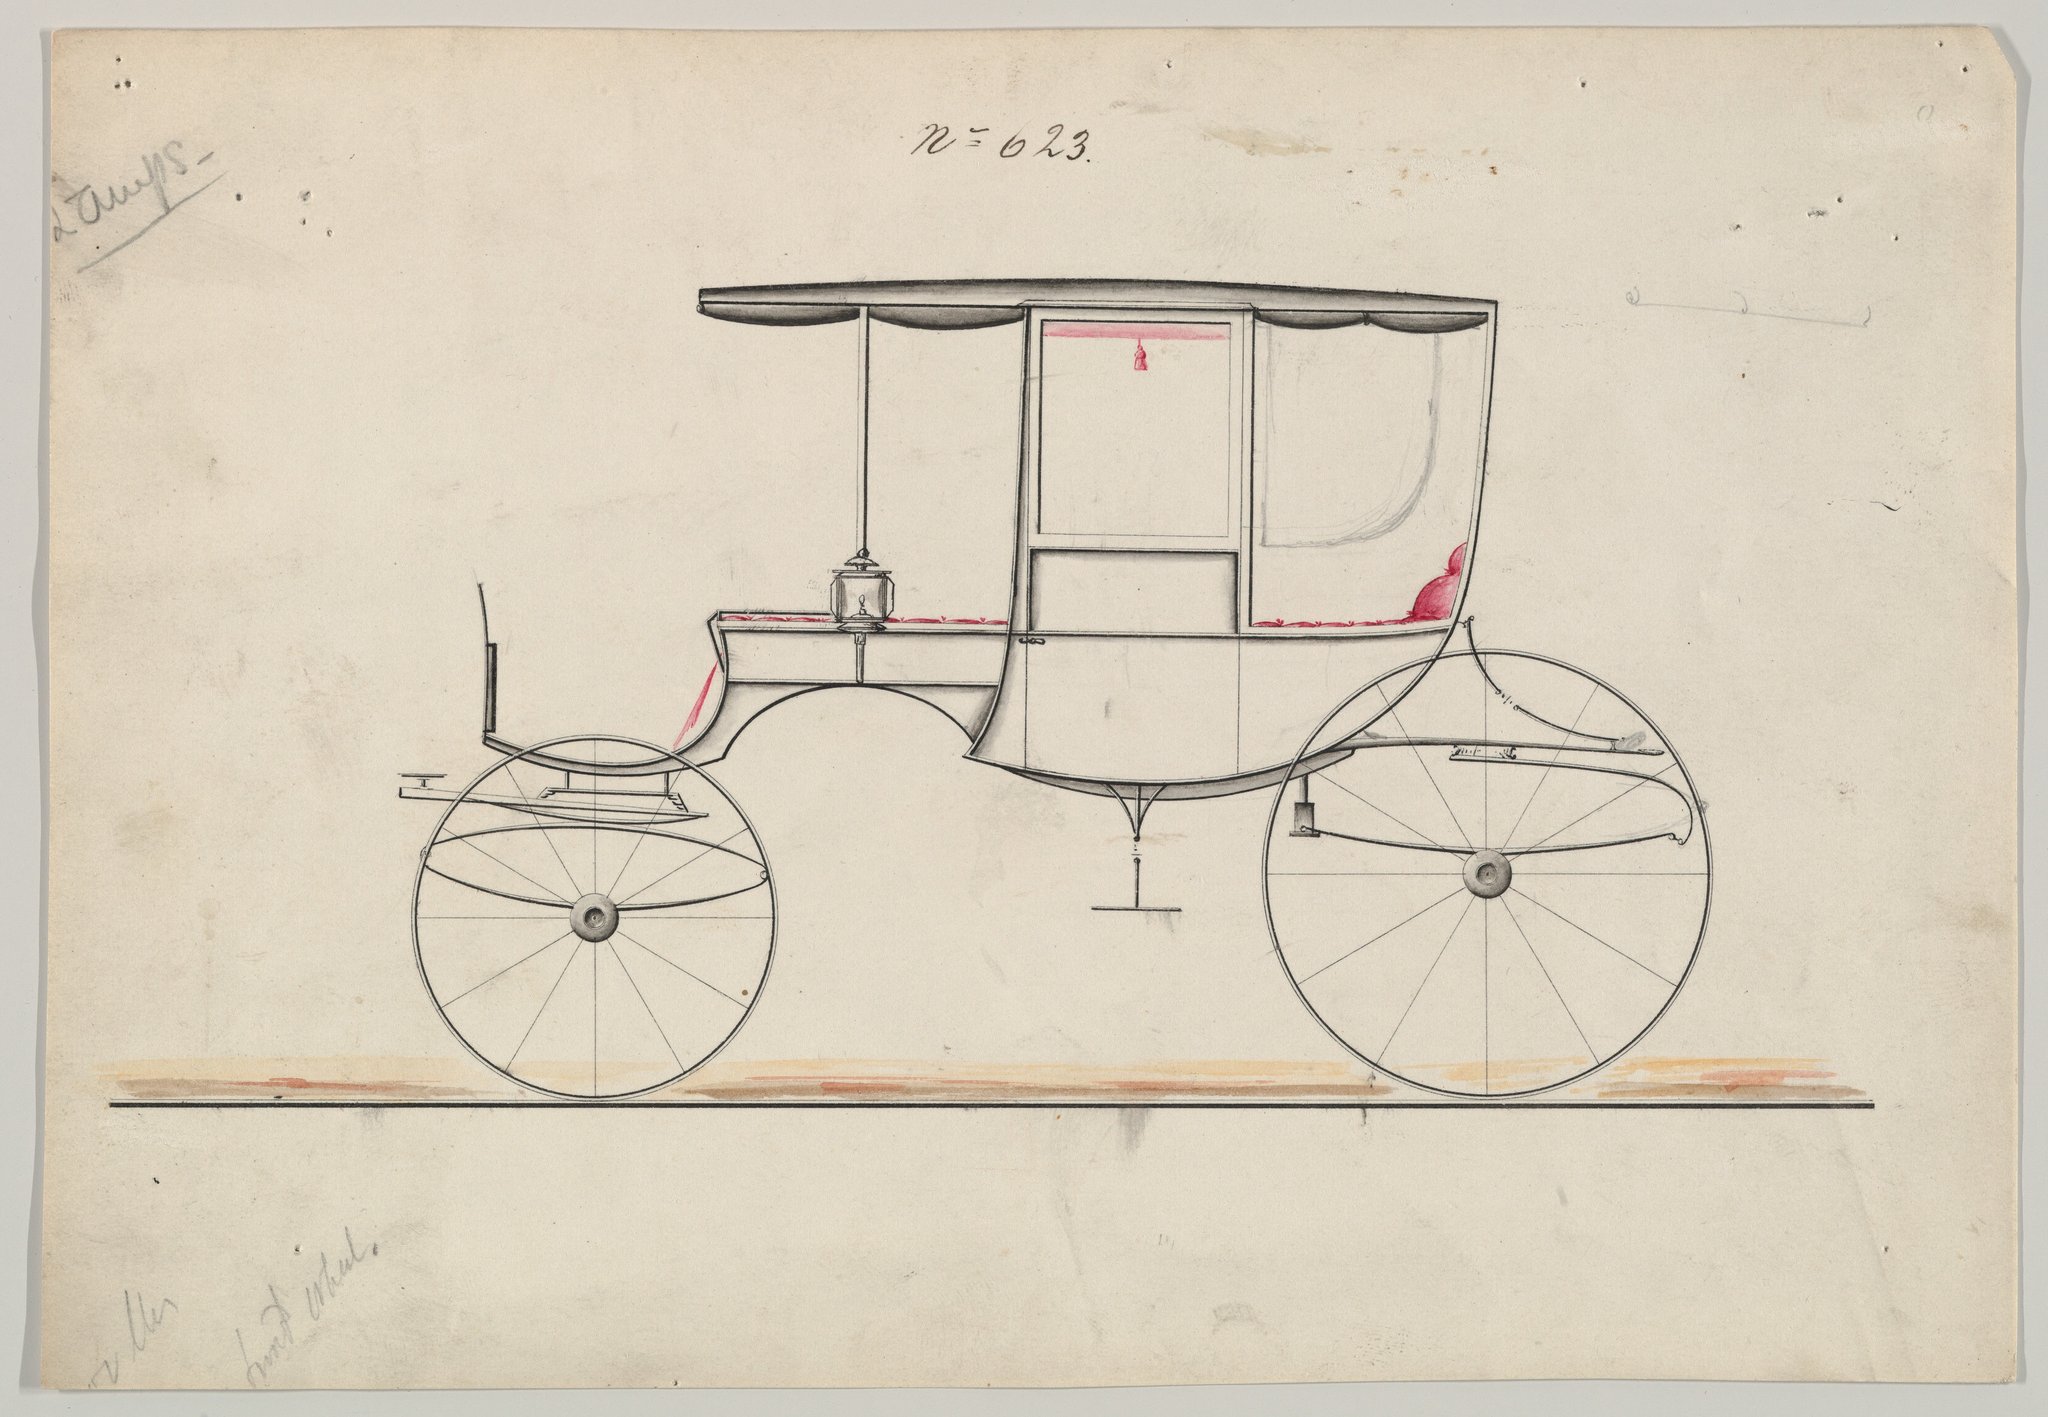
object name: drawing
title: Rockaway #623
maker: brewster & co.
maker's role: manufacturer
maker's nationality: american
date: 1865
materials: graphite, ink, watercolor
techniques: pen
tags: carriages